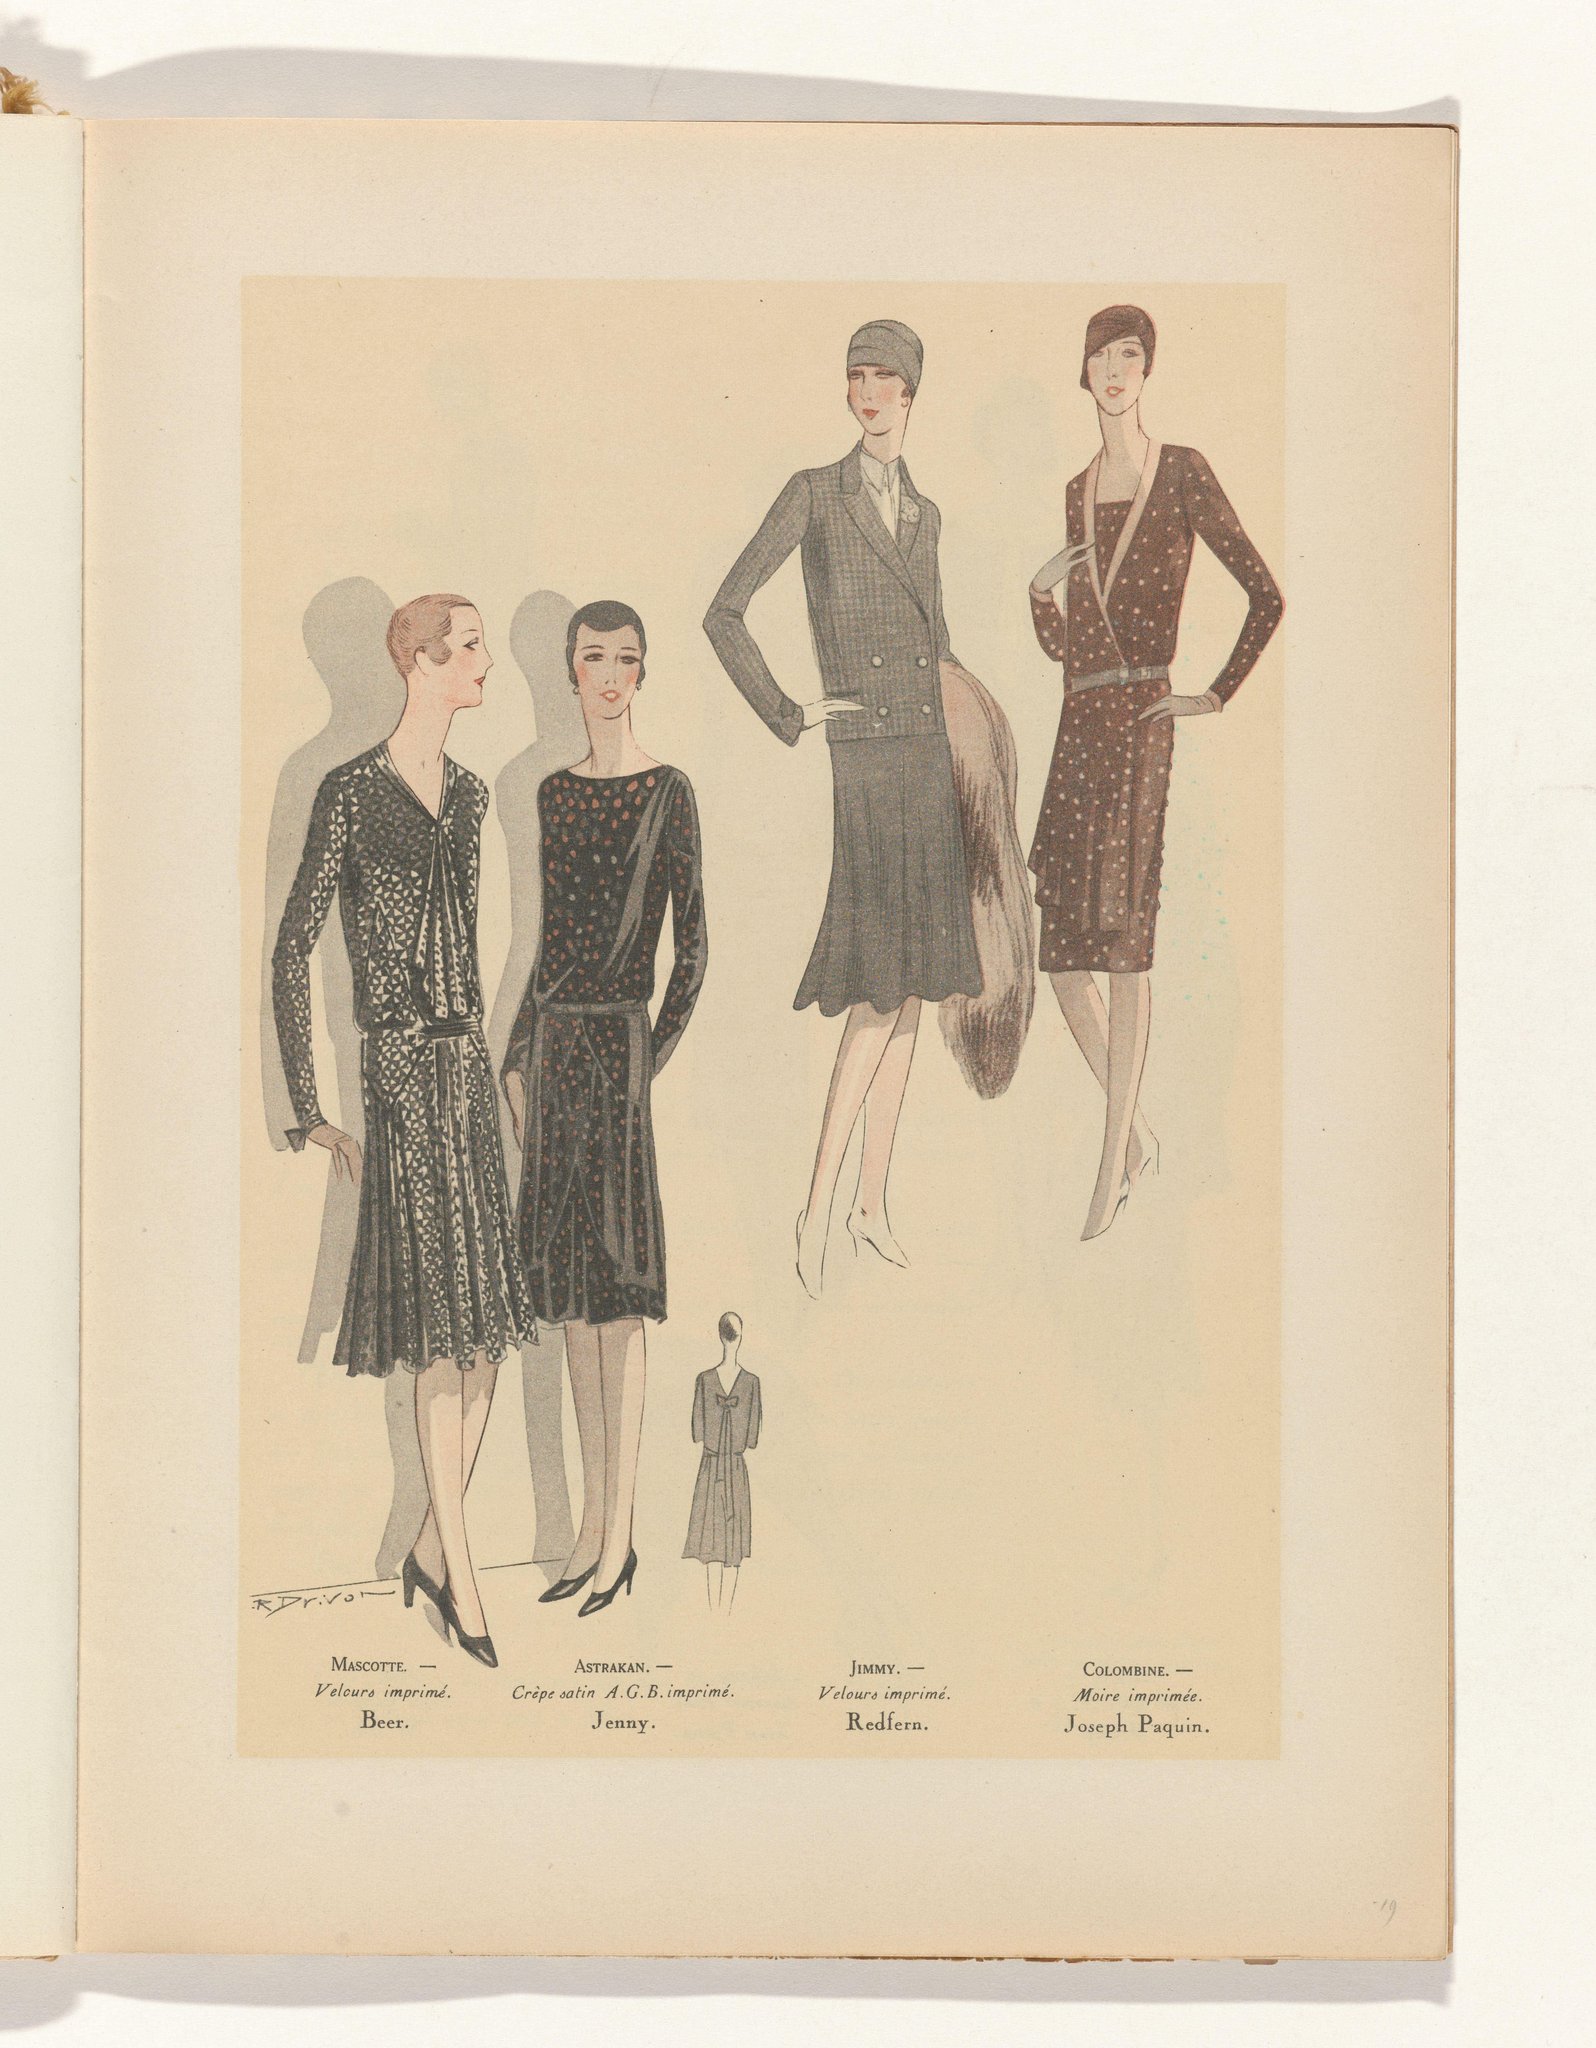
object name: fashion print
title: Art - Goût - Beauté, Feuillets de l' élégance féminine, Novembre 1928, No. 99, 9e Année, p. 19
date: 1928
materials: paper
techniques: printing, photography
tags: ensembles of pieces of clothing (two piece suit) (+ women's clothes), styles of hairdress (à la garconne) - aa - ~ women, fashion plates, head-gear: hat (+ women's clothes), dress, gown (+ women's clothes), clothing for the upper part of the body (shawl) (+ fur used for clothes), belt, girdle, waistband (+ women's clothes)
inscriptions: caption: ‘MASCOTTE. - Velours imrpimé. Beer. / ASTRAKAN. - Crêpe satin A.G.B. imprimé. Jenny. / JIMMY. - Velours imprimé. Redfern. / COLOMBINE. - Moire imprimée. Joseph Paquin.’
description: Vier modellen met korte kapsels. Van links naar rechts: japon van bedrukt fluweel, van Beer. Japon van bedrukte 'crêpe satin' A.G.B, van Jenny. Japon of deux-pièces van bedrukt fluweel, van Redfern. Japon van bedrukte 'moiré', van Joseph Paquin. Pagina uit het modetijdschrift Art-Goût-Beauté (1920-1933).